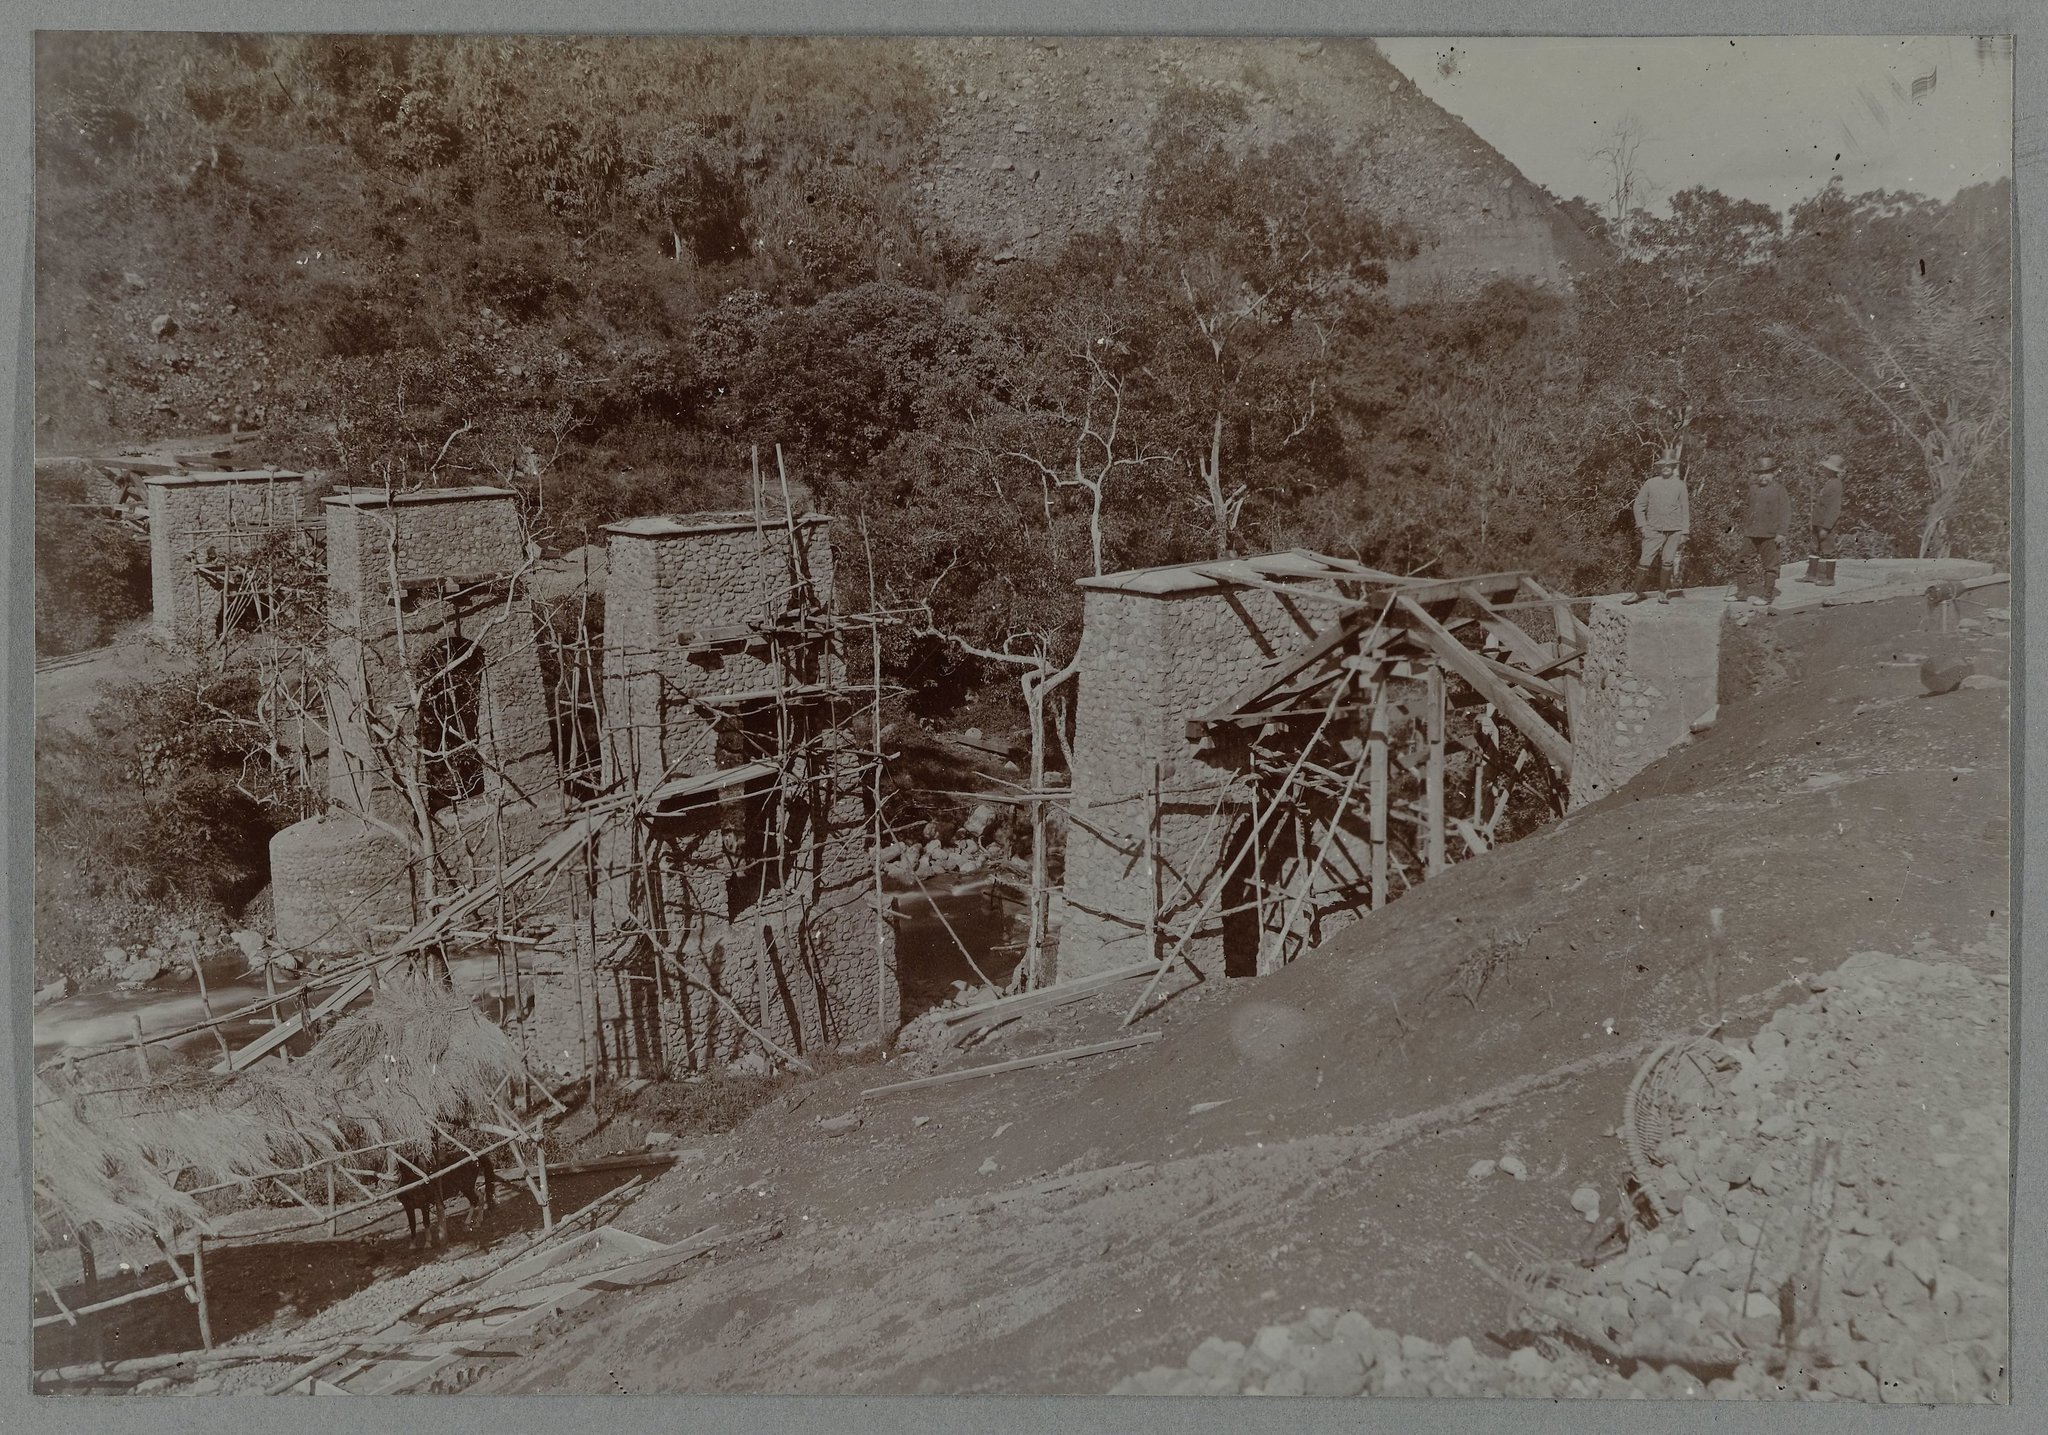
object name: photograph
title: Bouw van de brug over de Woih ni Enang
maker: Anonymous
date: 1903-1913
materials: photographic support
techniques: photography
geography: north sumatra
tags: arnhem, albertus dominicus laman trip, building activities, traffic by road or path with motor-vehicle, landscapes in tropical and sub-tropical regions, road, path, bridge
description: Na de expedities naar de Gajo- en Alaslanden o.l.v. Van Daalen (eerste tocht in 1901), werd hij in 1903 belast met voorbereiding van permanente vestiging van Nederlands gezag. Aanleg van een weg van de Noordkust naar het binnenland was hierbij van groot belang. Deze zgn. Gajoweg werd aangelegd tussen 1903 en 1914, van Bireuen aan de kust naar Takinguen aan het bergmeer Danau Lauttawar, totale lente 104 km.